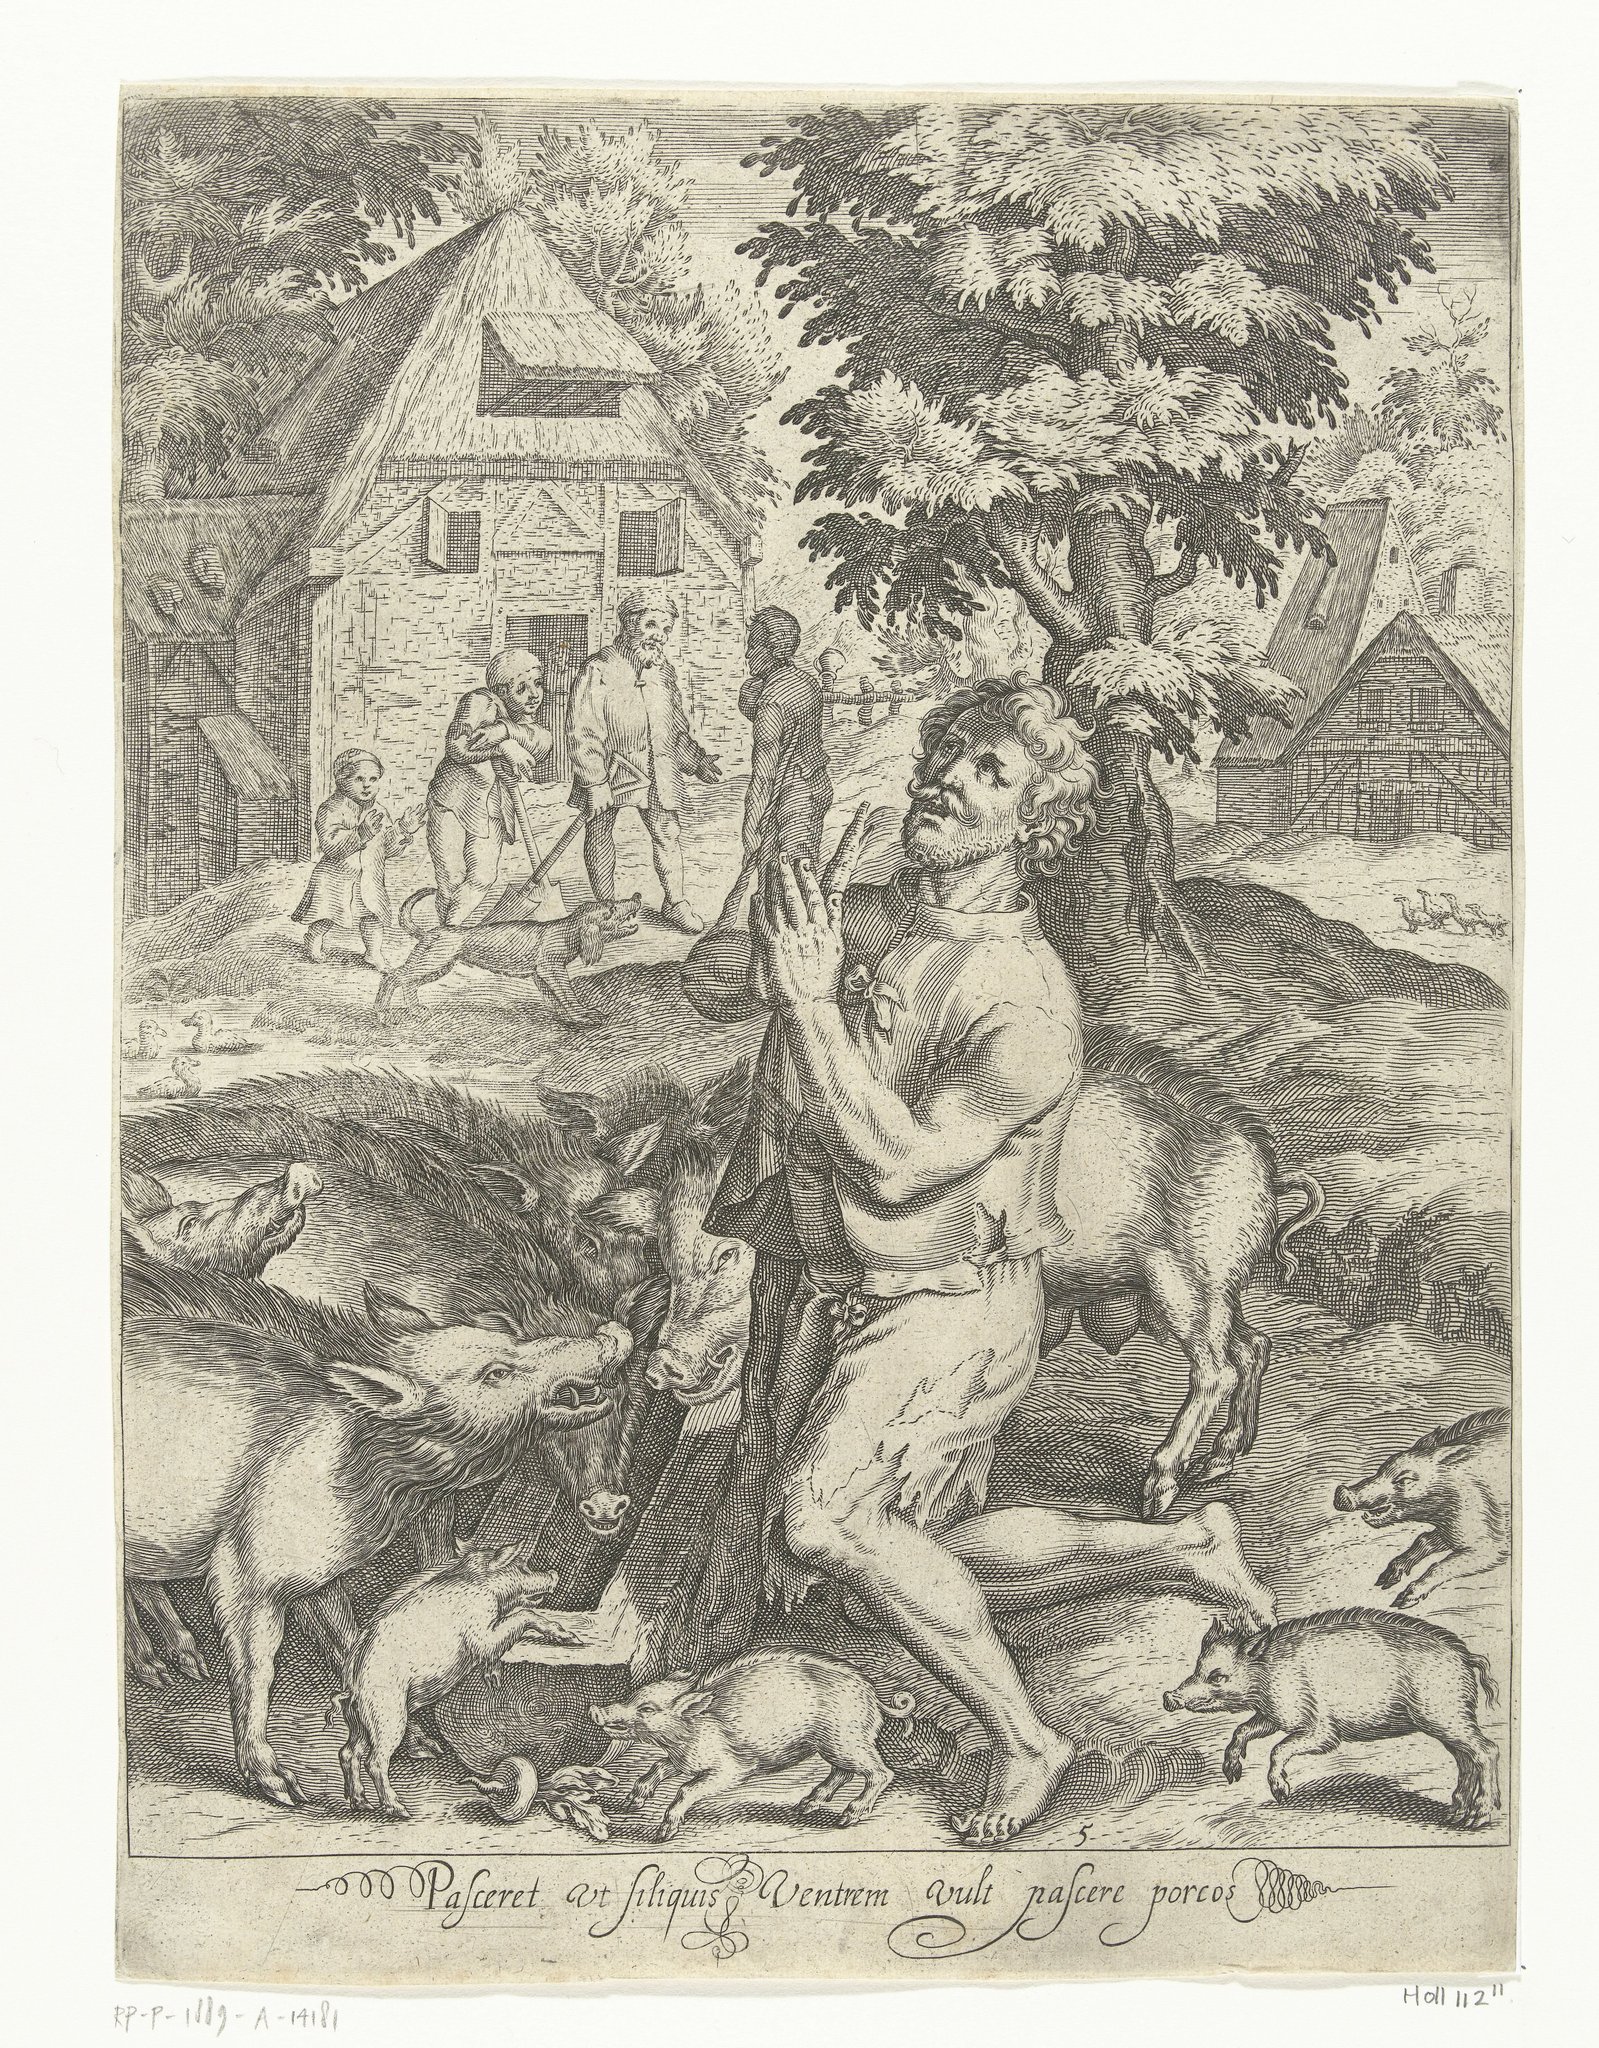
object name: print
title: Verloren zoon als varkenshoeder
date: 1581-1656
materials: paper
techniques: engraving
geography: netherlands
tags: the prodigal son tends the swine and eats from their trough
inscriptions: collector's mark: Lugt 2228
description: Prent uit serie van zes prenten met het verhaal van de verloren zoon.